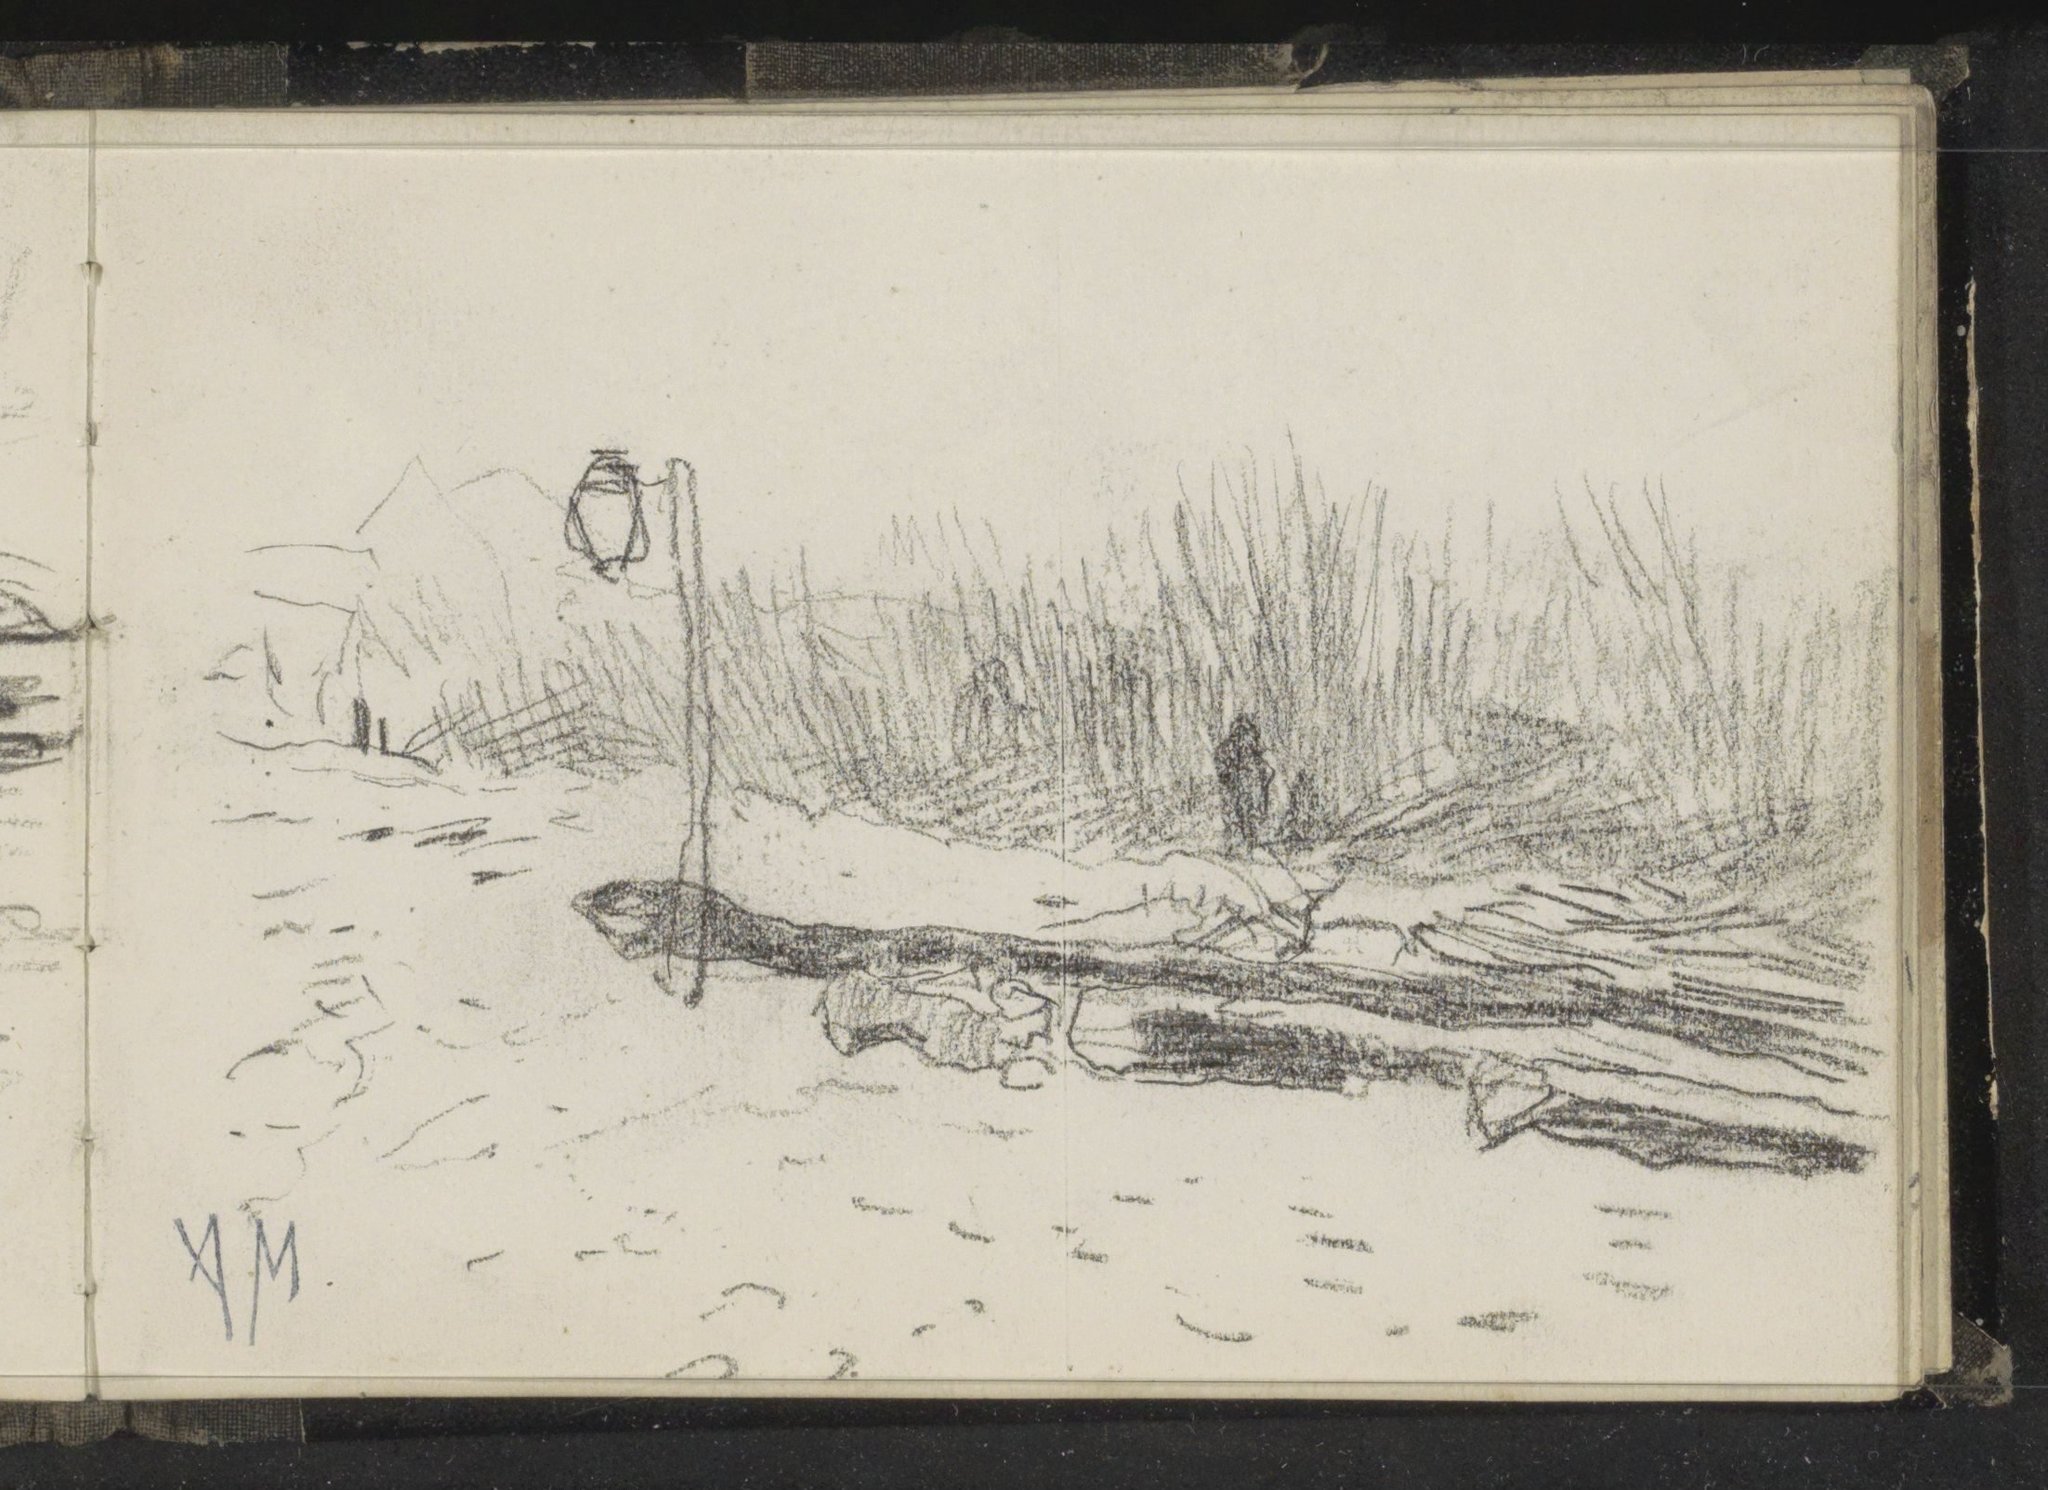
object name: sketchbook leaf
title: Landschap met sprokkelhout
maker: anton mauve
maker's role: draughtsman, painter, print maker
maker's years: 1838-1888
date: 1848-1888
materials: chalk, paper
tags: landscapes (+ landscape with figures, staffage), trees (+ parts of plants)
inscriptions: monogram: ‘AM’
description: Op de achtergrond zijn mogelijk figuren tussen het gras te zien. Blad 21 recto uit een schetsboek met 33 bladen.